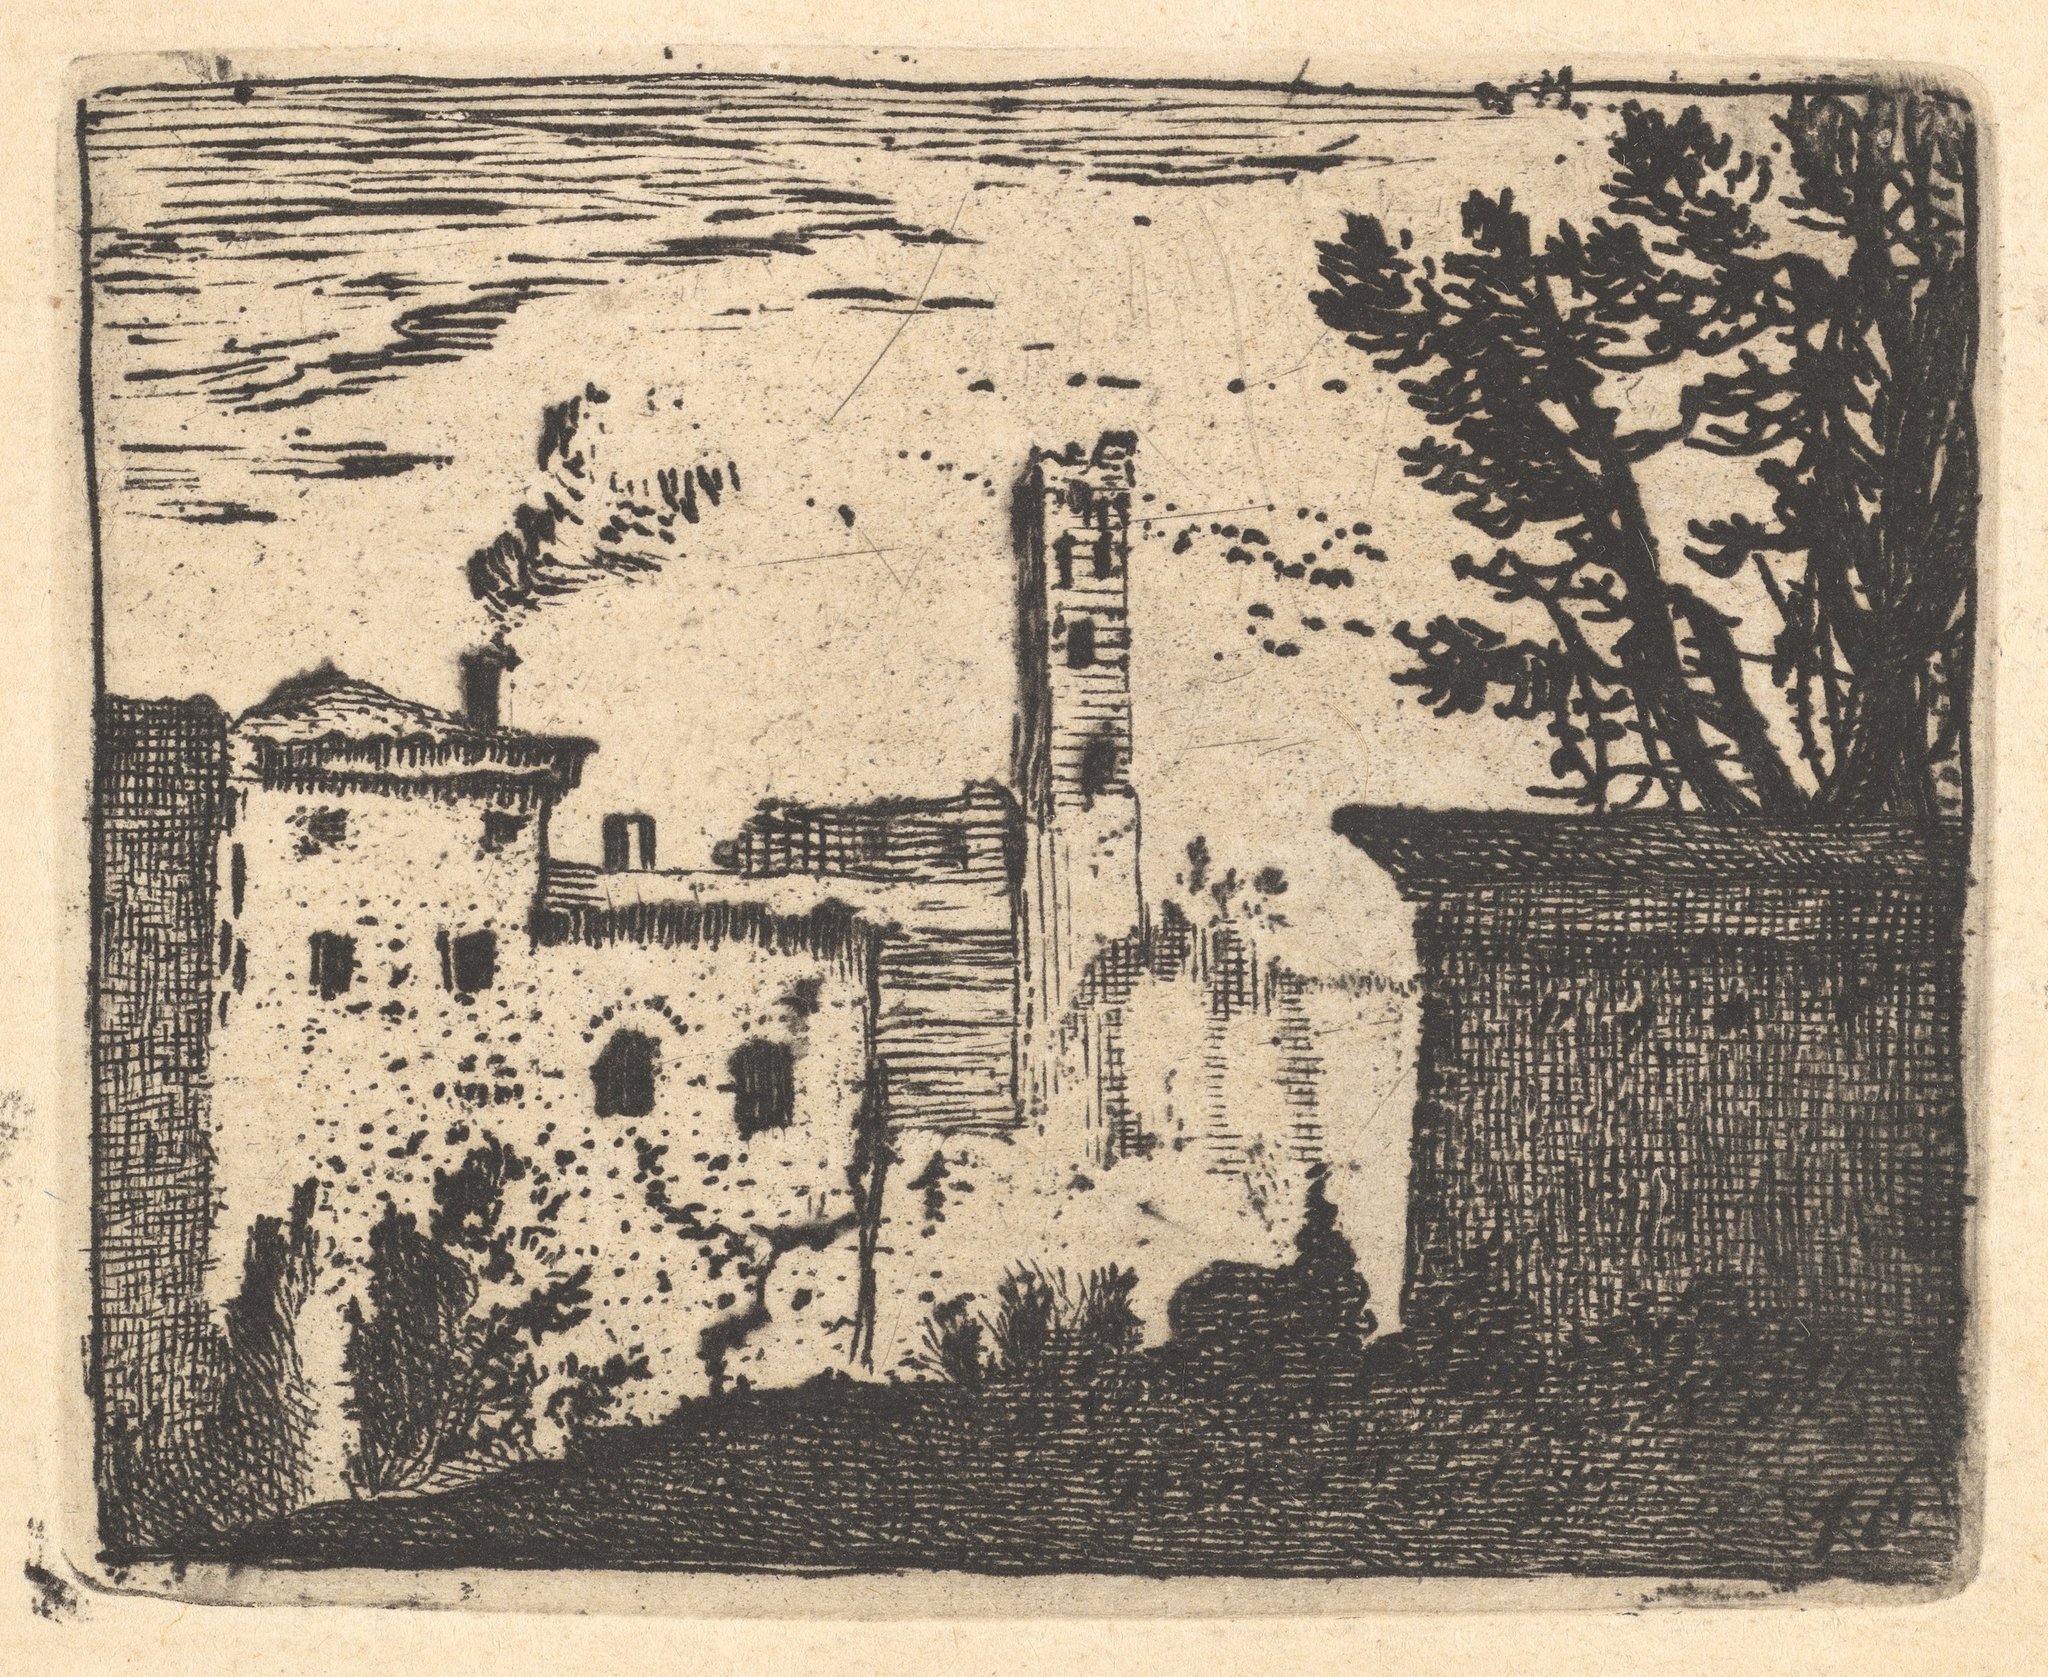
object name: print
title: Townscape with wall and foliage in shadow in right foreground, buildings with smoking chimney and square tower beyond, from "The Small Landscapes"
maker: karel dujardin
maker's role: artist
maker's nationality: dutch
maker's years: 1622-1678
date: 1641-1678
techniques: etching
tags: buildings,towers,towns